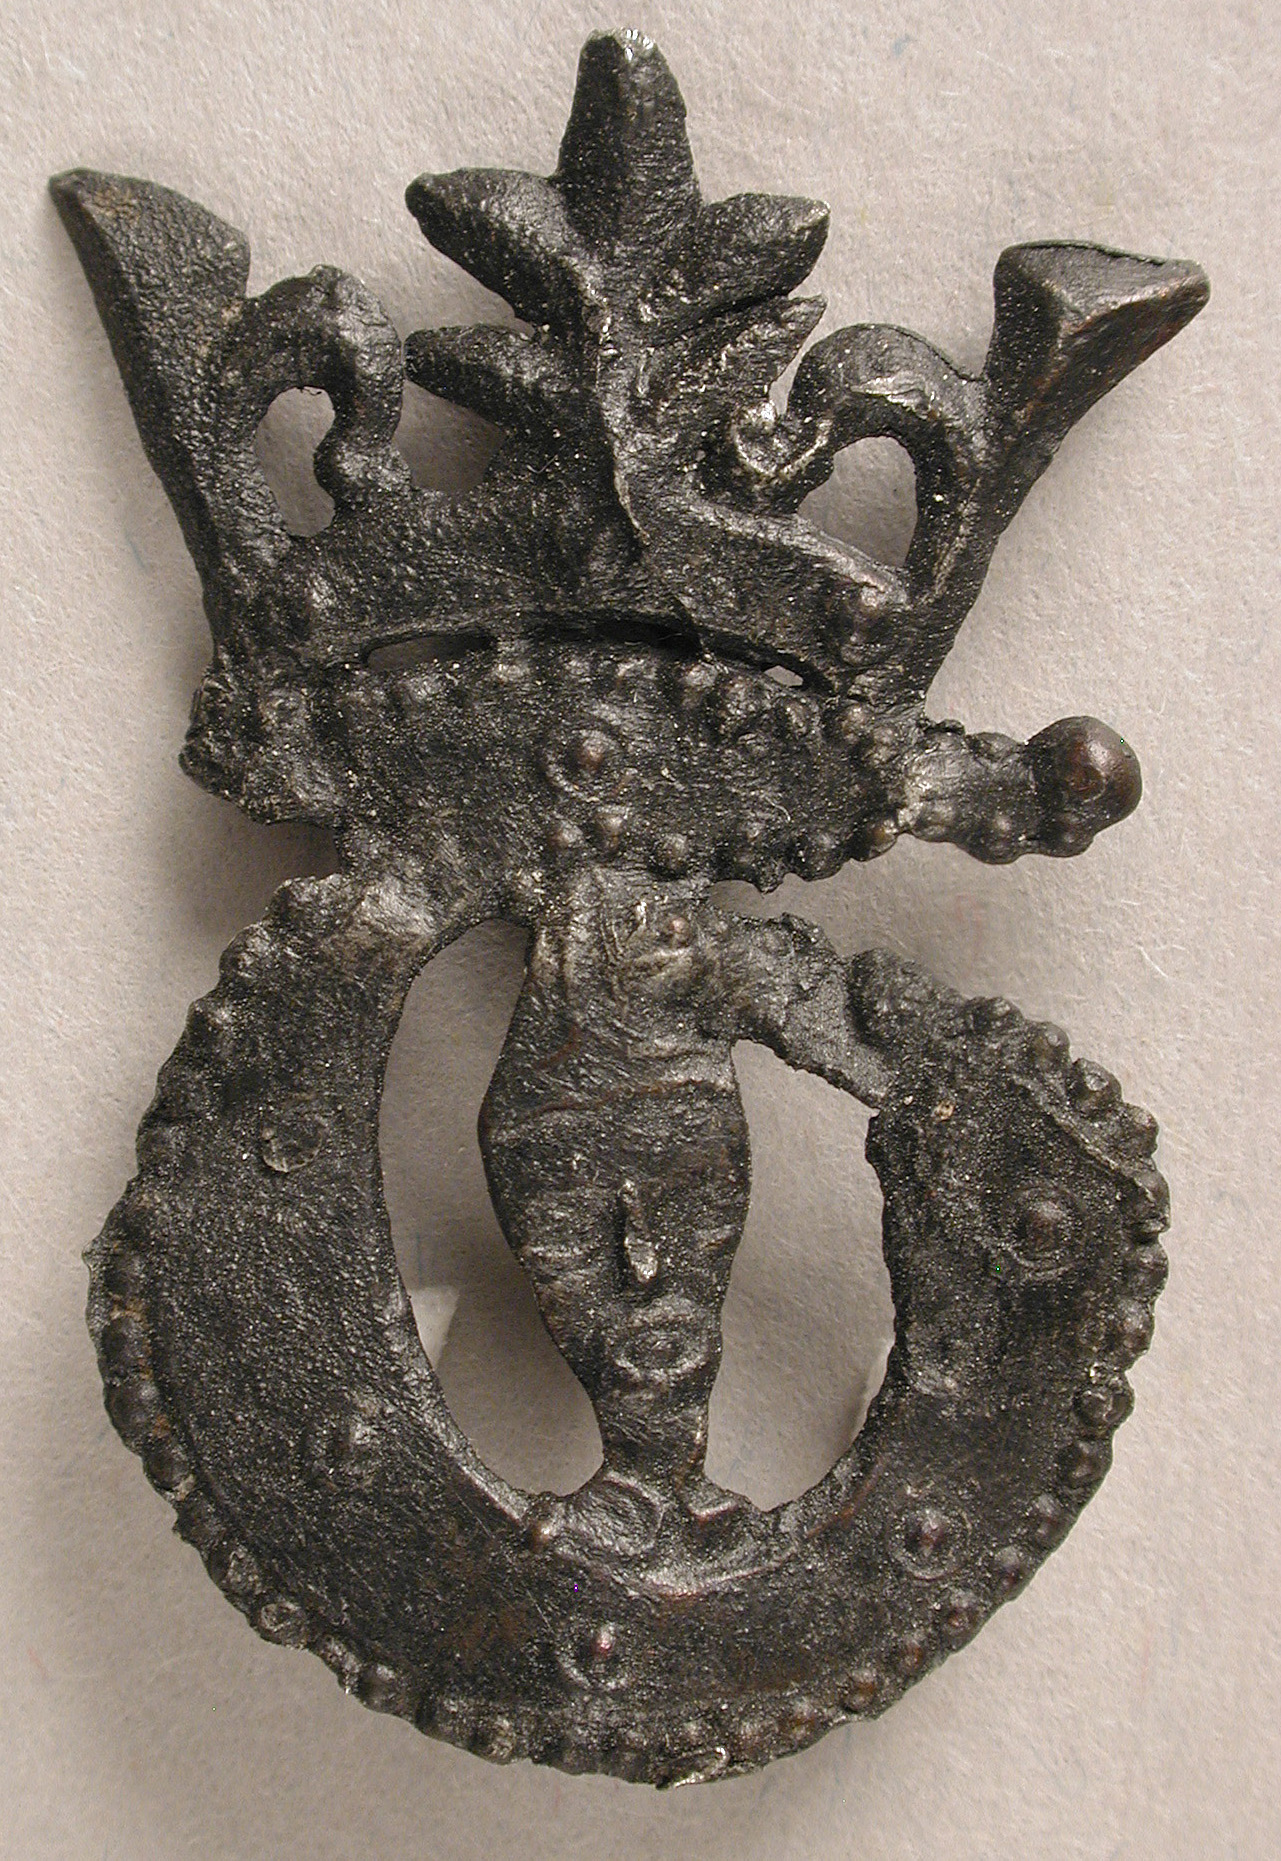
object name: pilgrim's badge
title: Badge with Bust of Crowned Becket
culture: british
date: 1401-1500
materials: alloy, lead, tin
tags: crowns